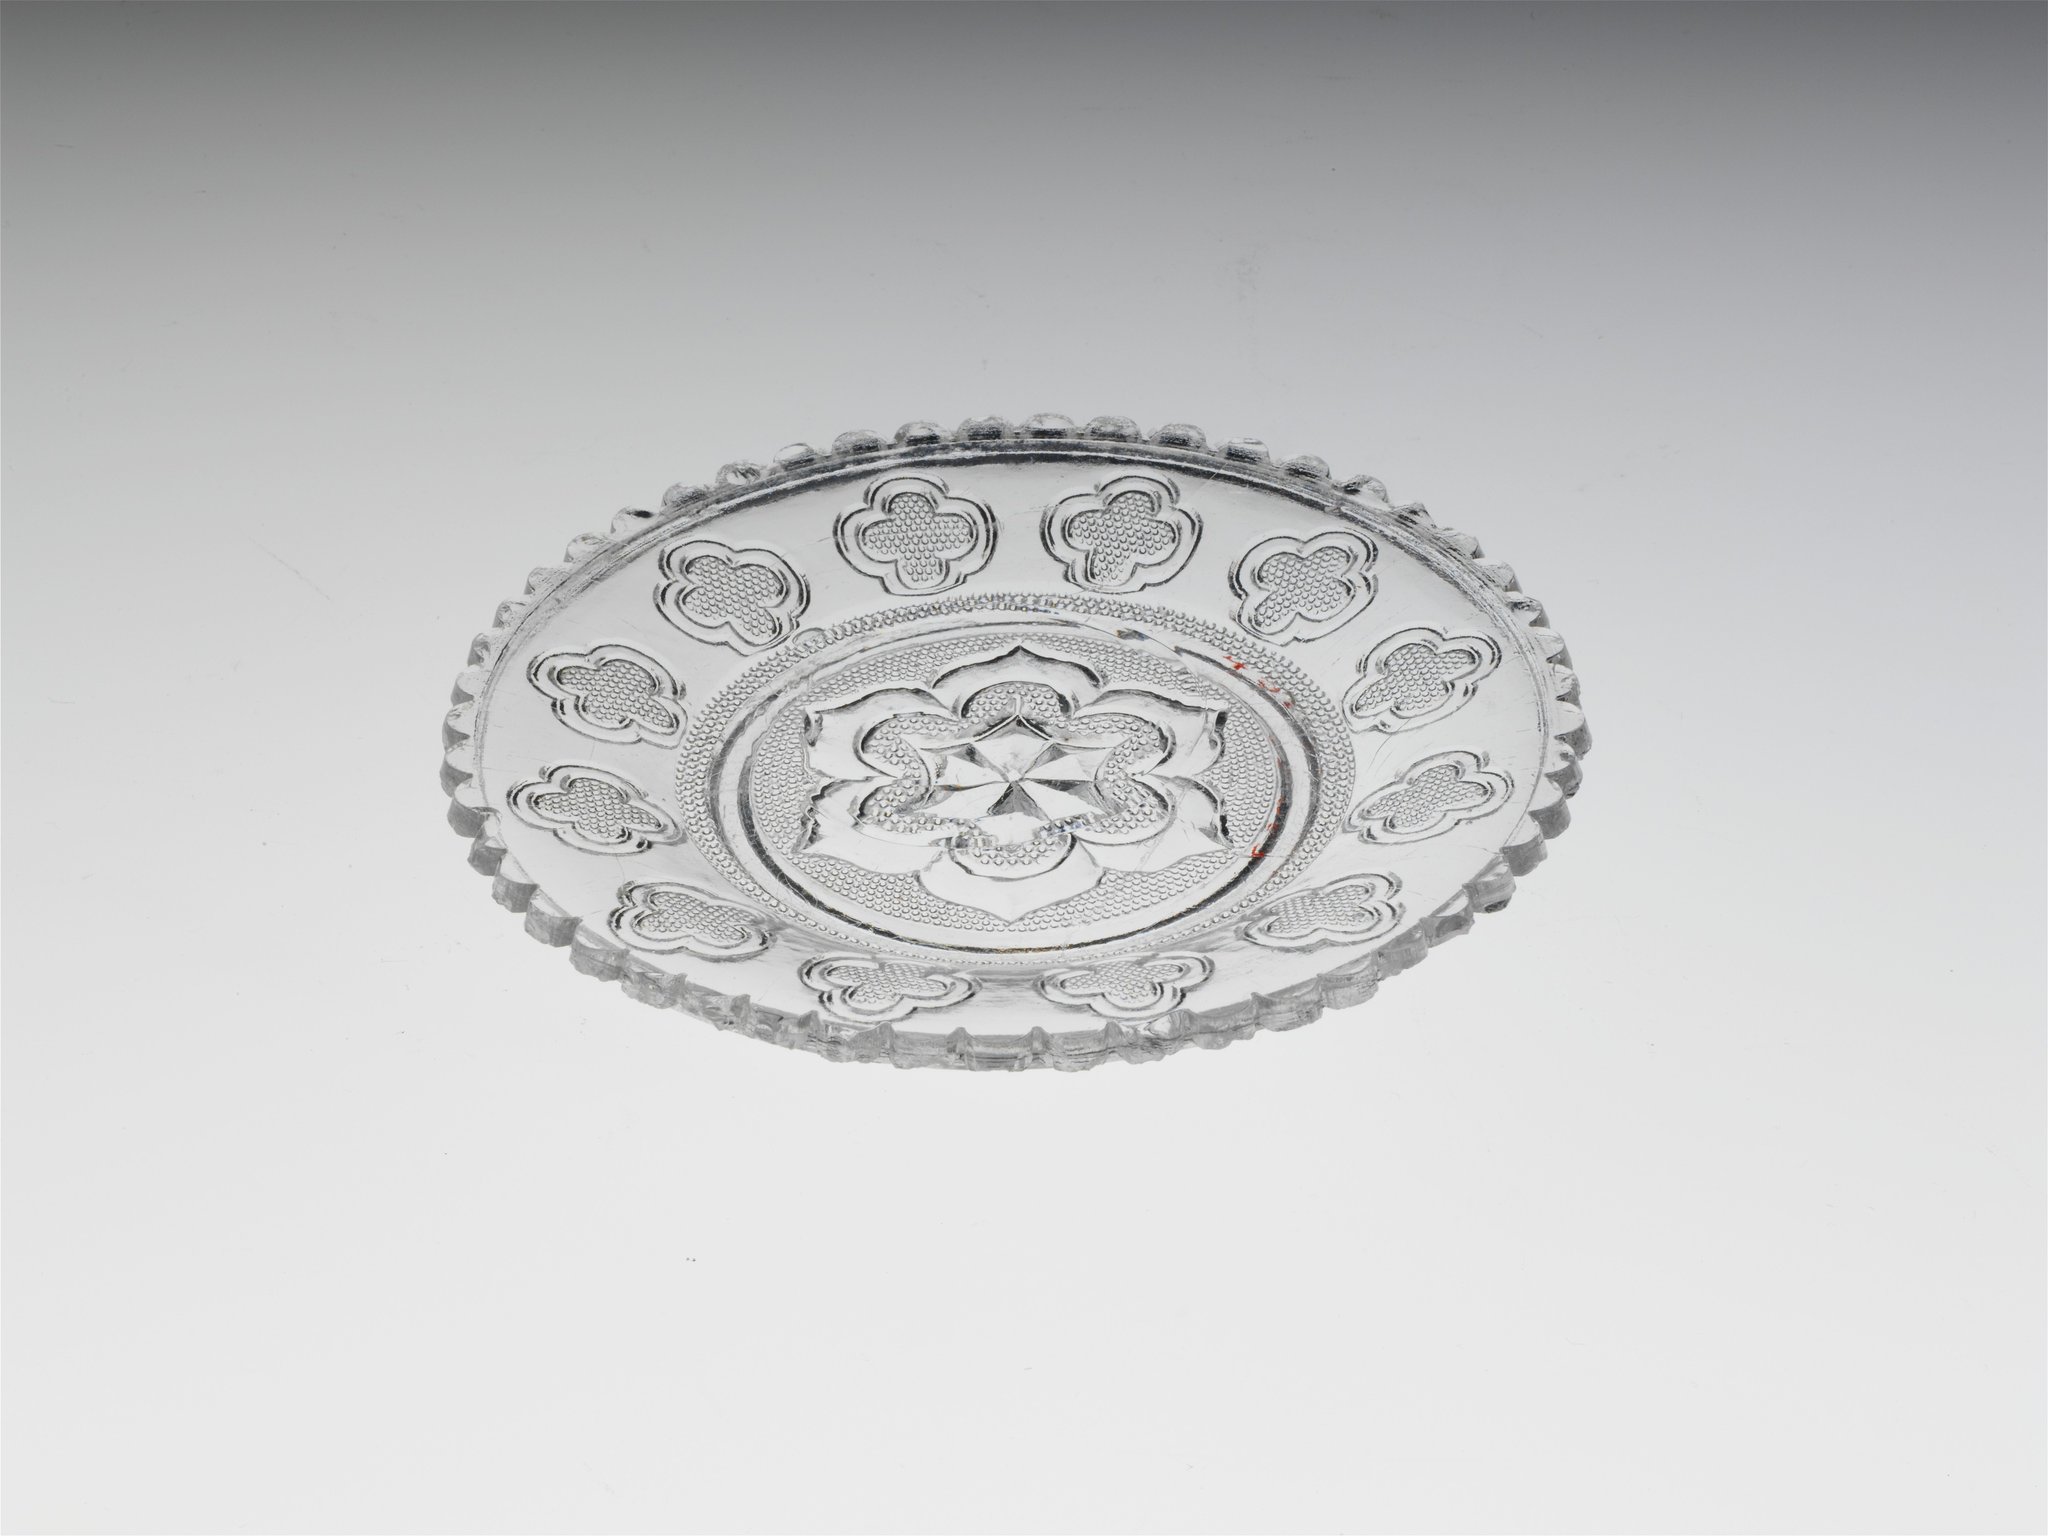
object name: cup plate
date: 1825-1860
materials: glass